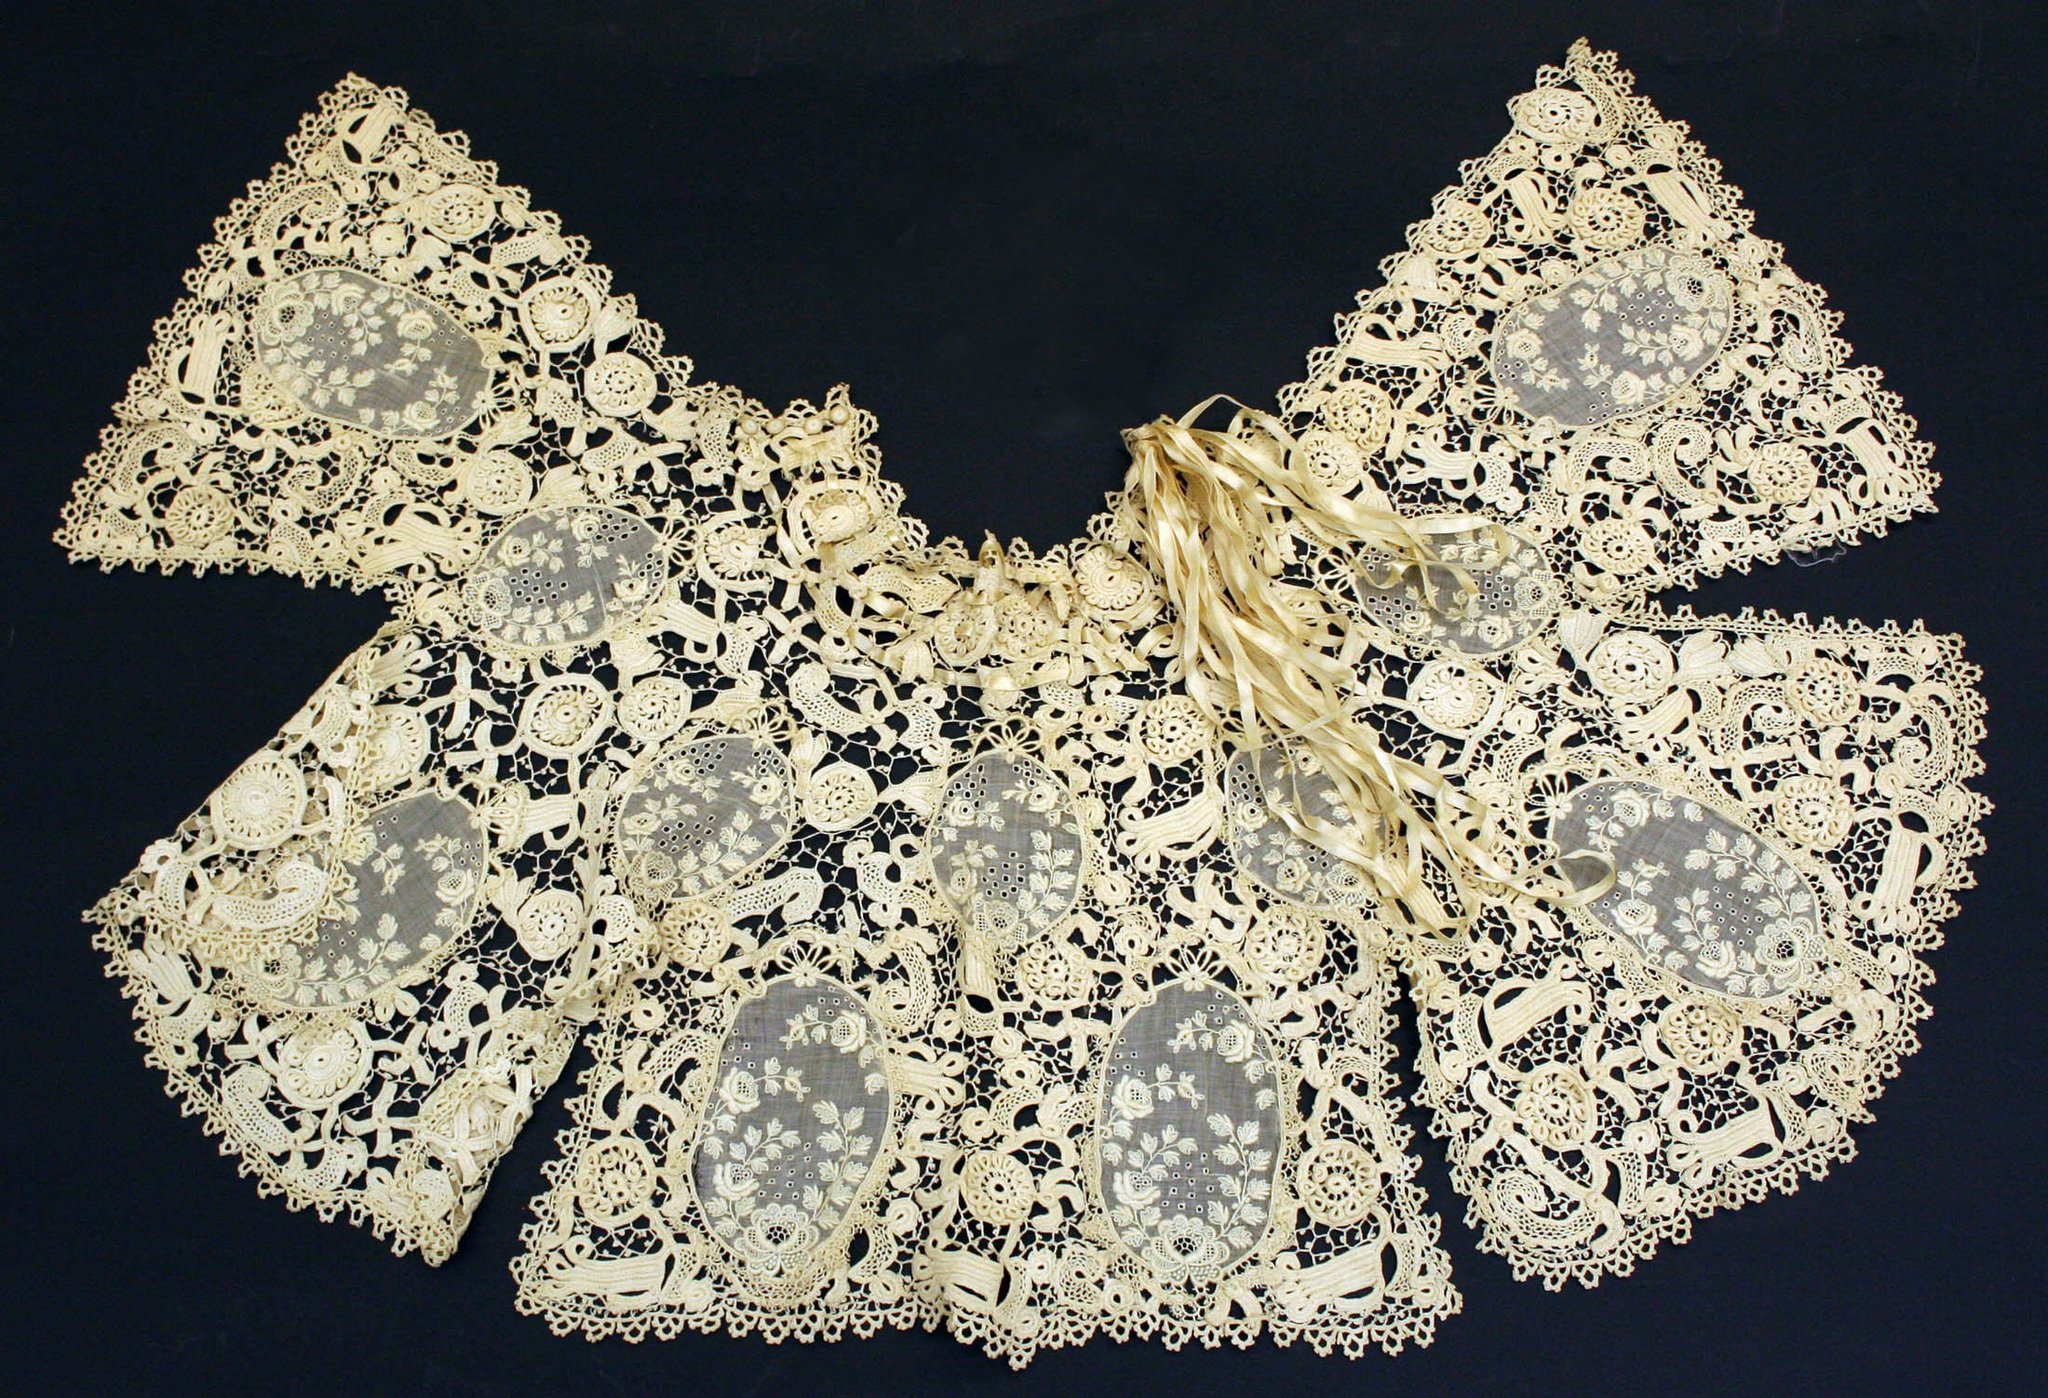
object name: collar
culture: french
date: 1867-1900